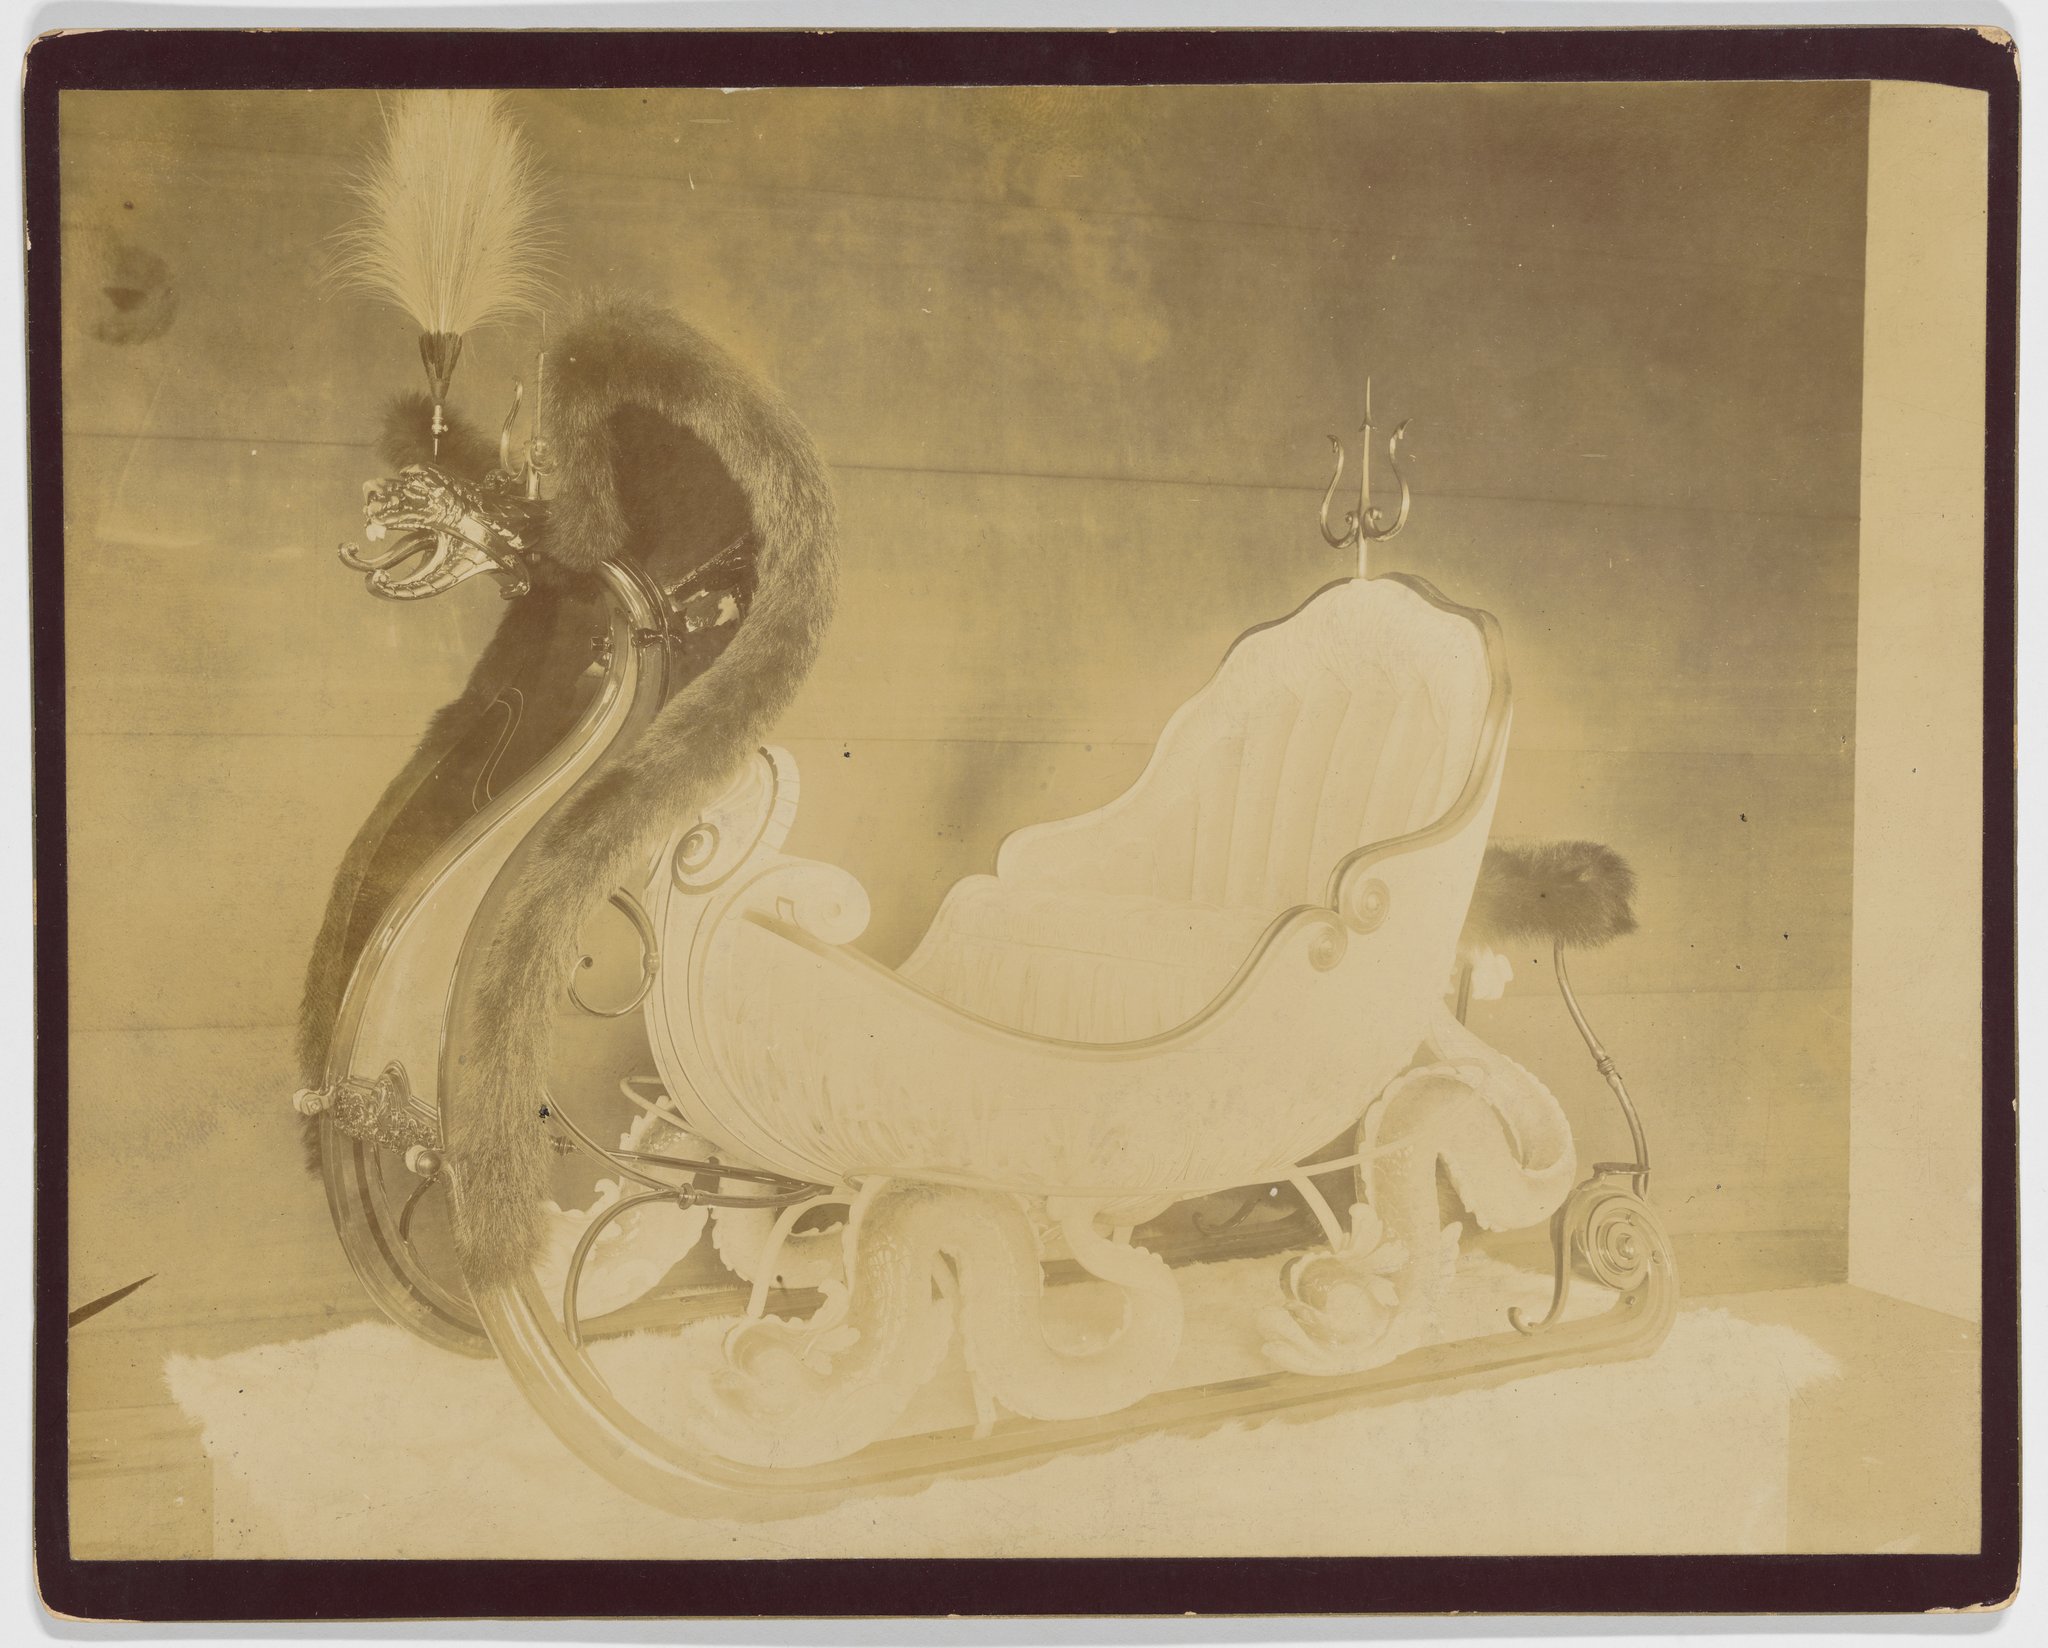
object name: drawing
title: Exhibition Sleigh #4200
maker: brewster & co.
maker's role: manufacturer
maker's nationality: american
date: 1893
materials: board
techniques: photography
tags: sleighs